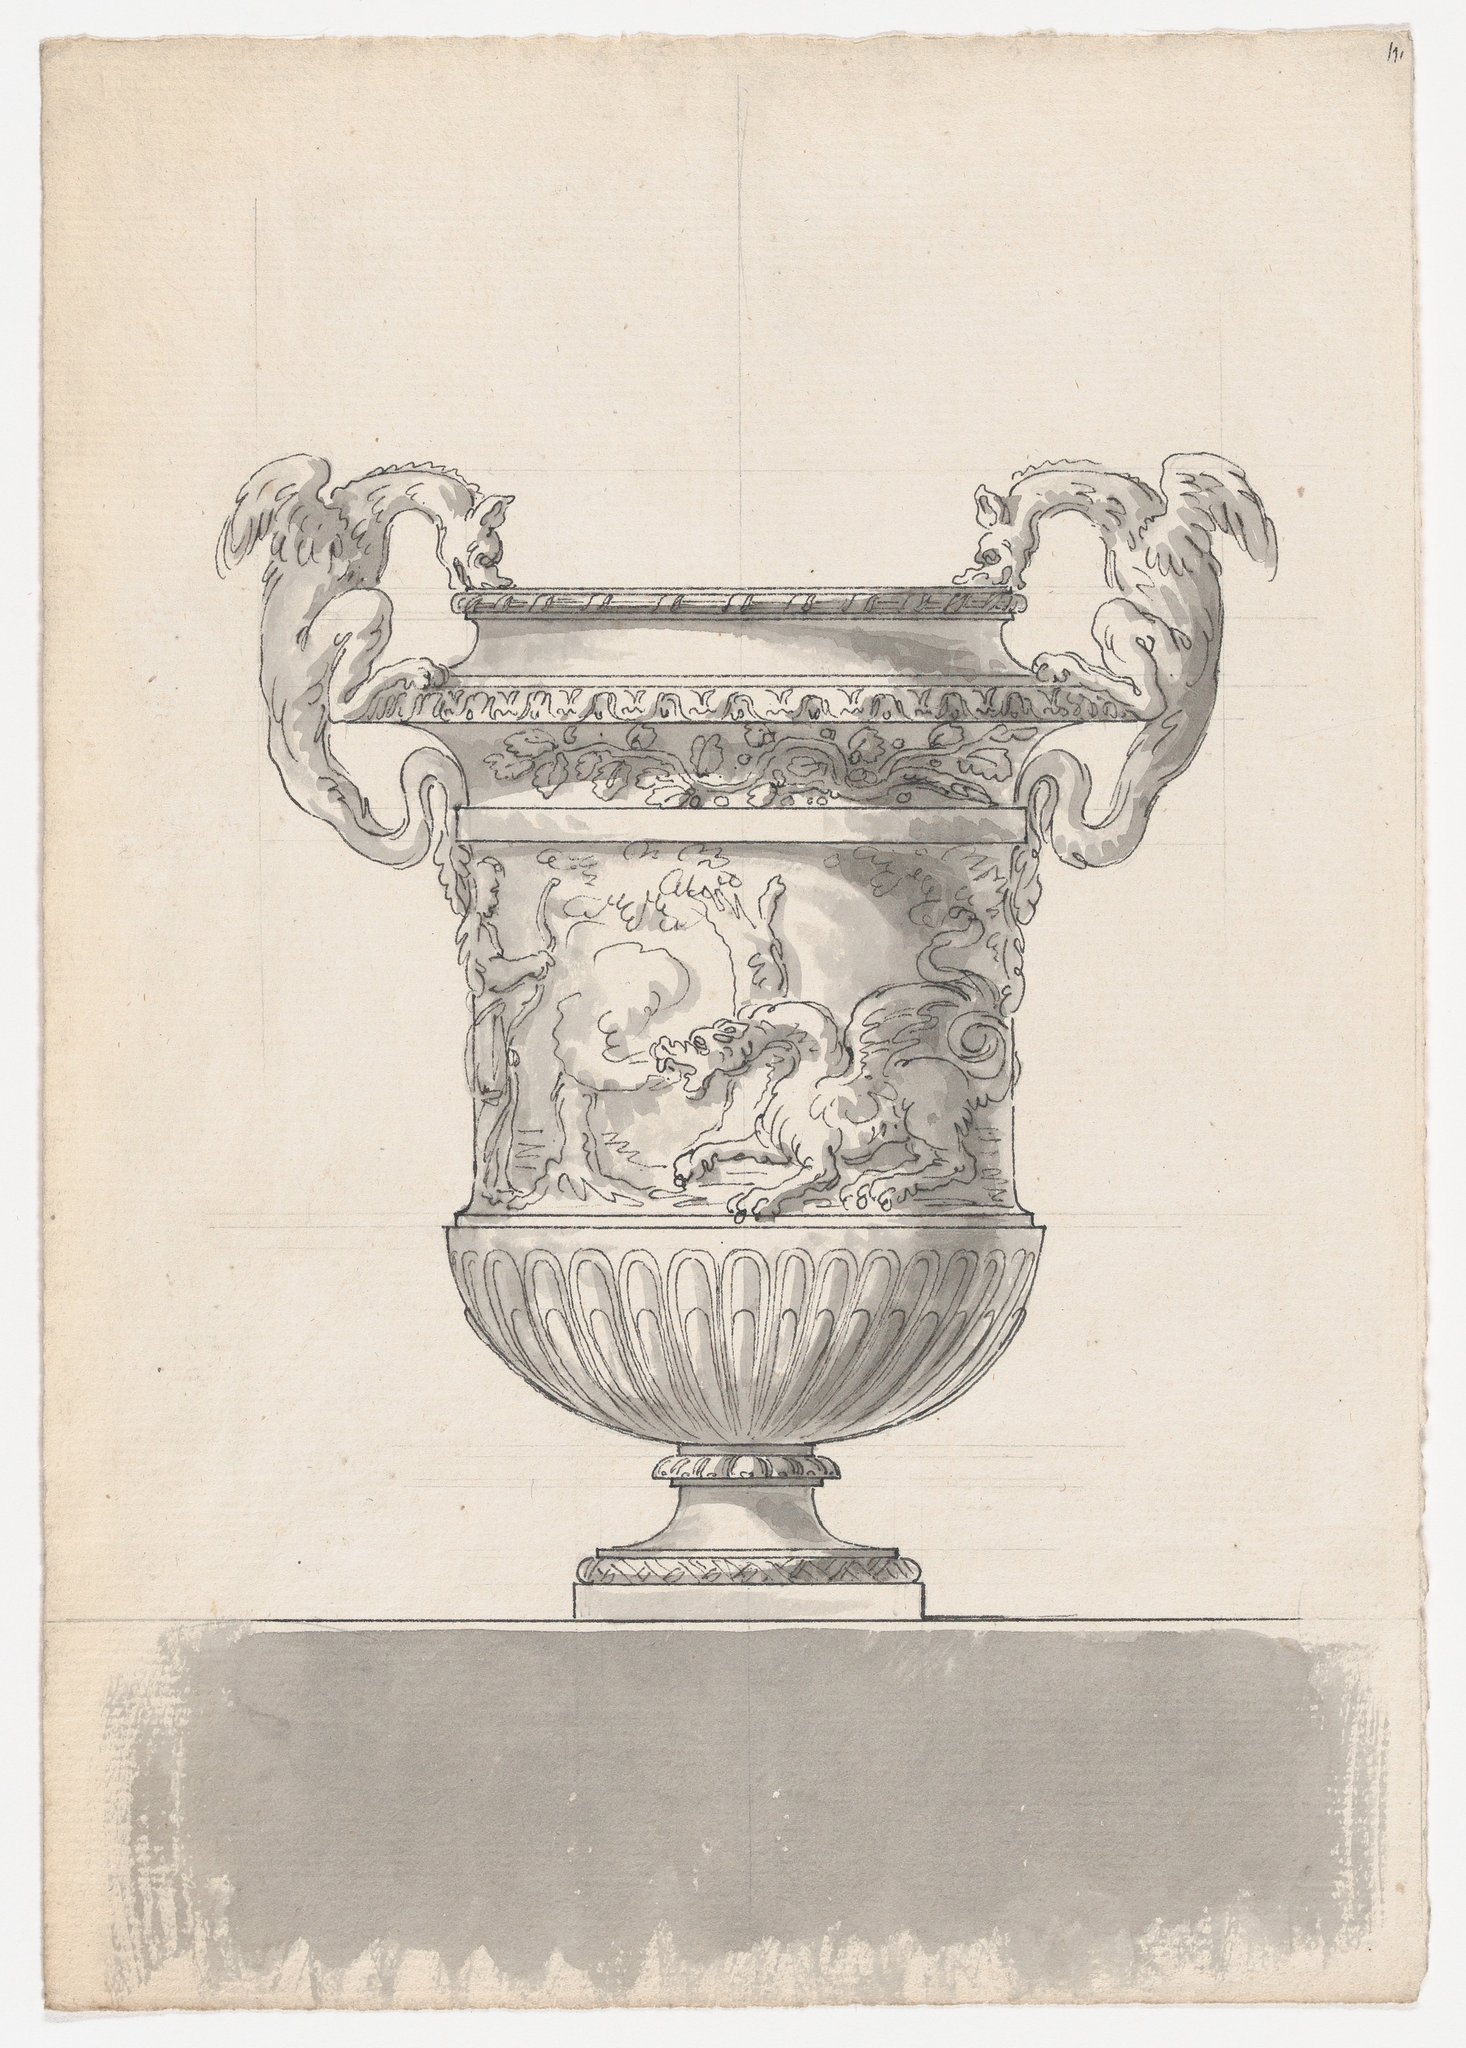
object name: drawing ornament architecture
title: Bronze Garden Vase with Two Dragons from the Gardens of Versailles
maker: claude ballin the elder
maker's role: artist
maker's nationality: french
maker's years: 1615-1678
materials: graphite, ink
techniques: pen, wash